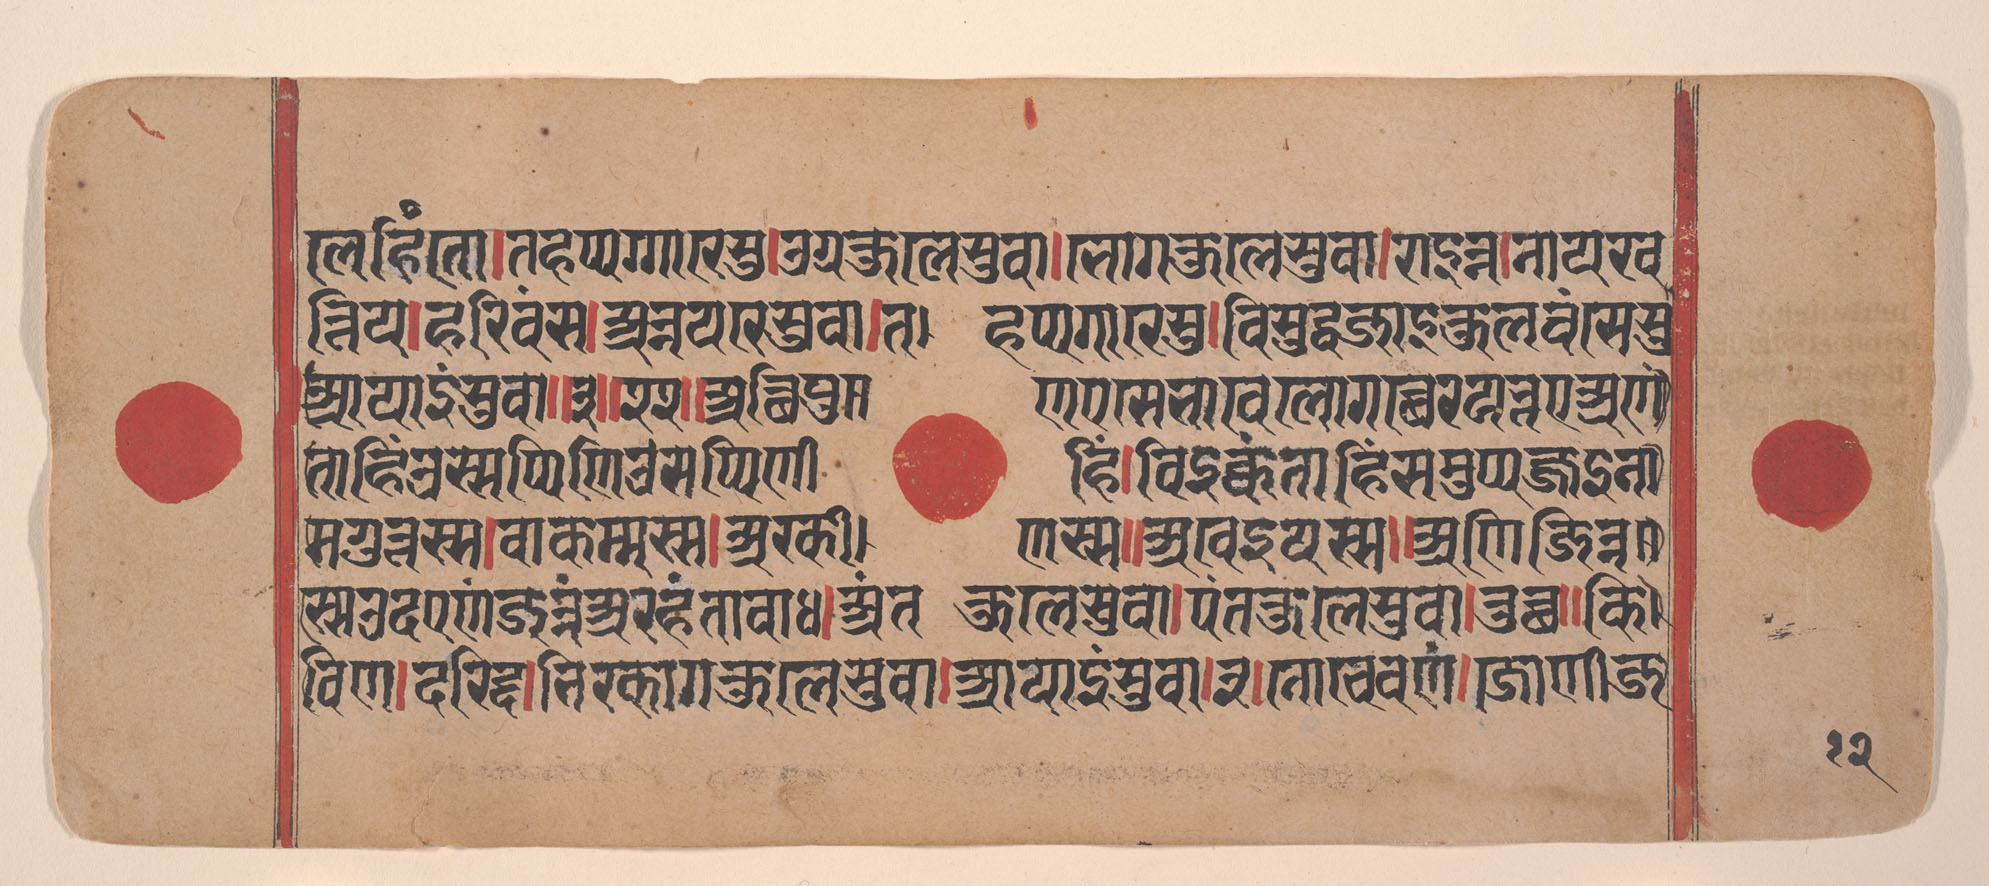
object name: folio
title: Page from a Dispersed Kalpa Sutra (Jain Book of Rituals)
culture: indian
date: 1401-1500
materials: gold, ink, paper, watercolor